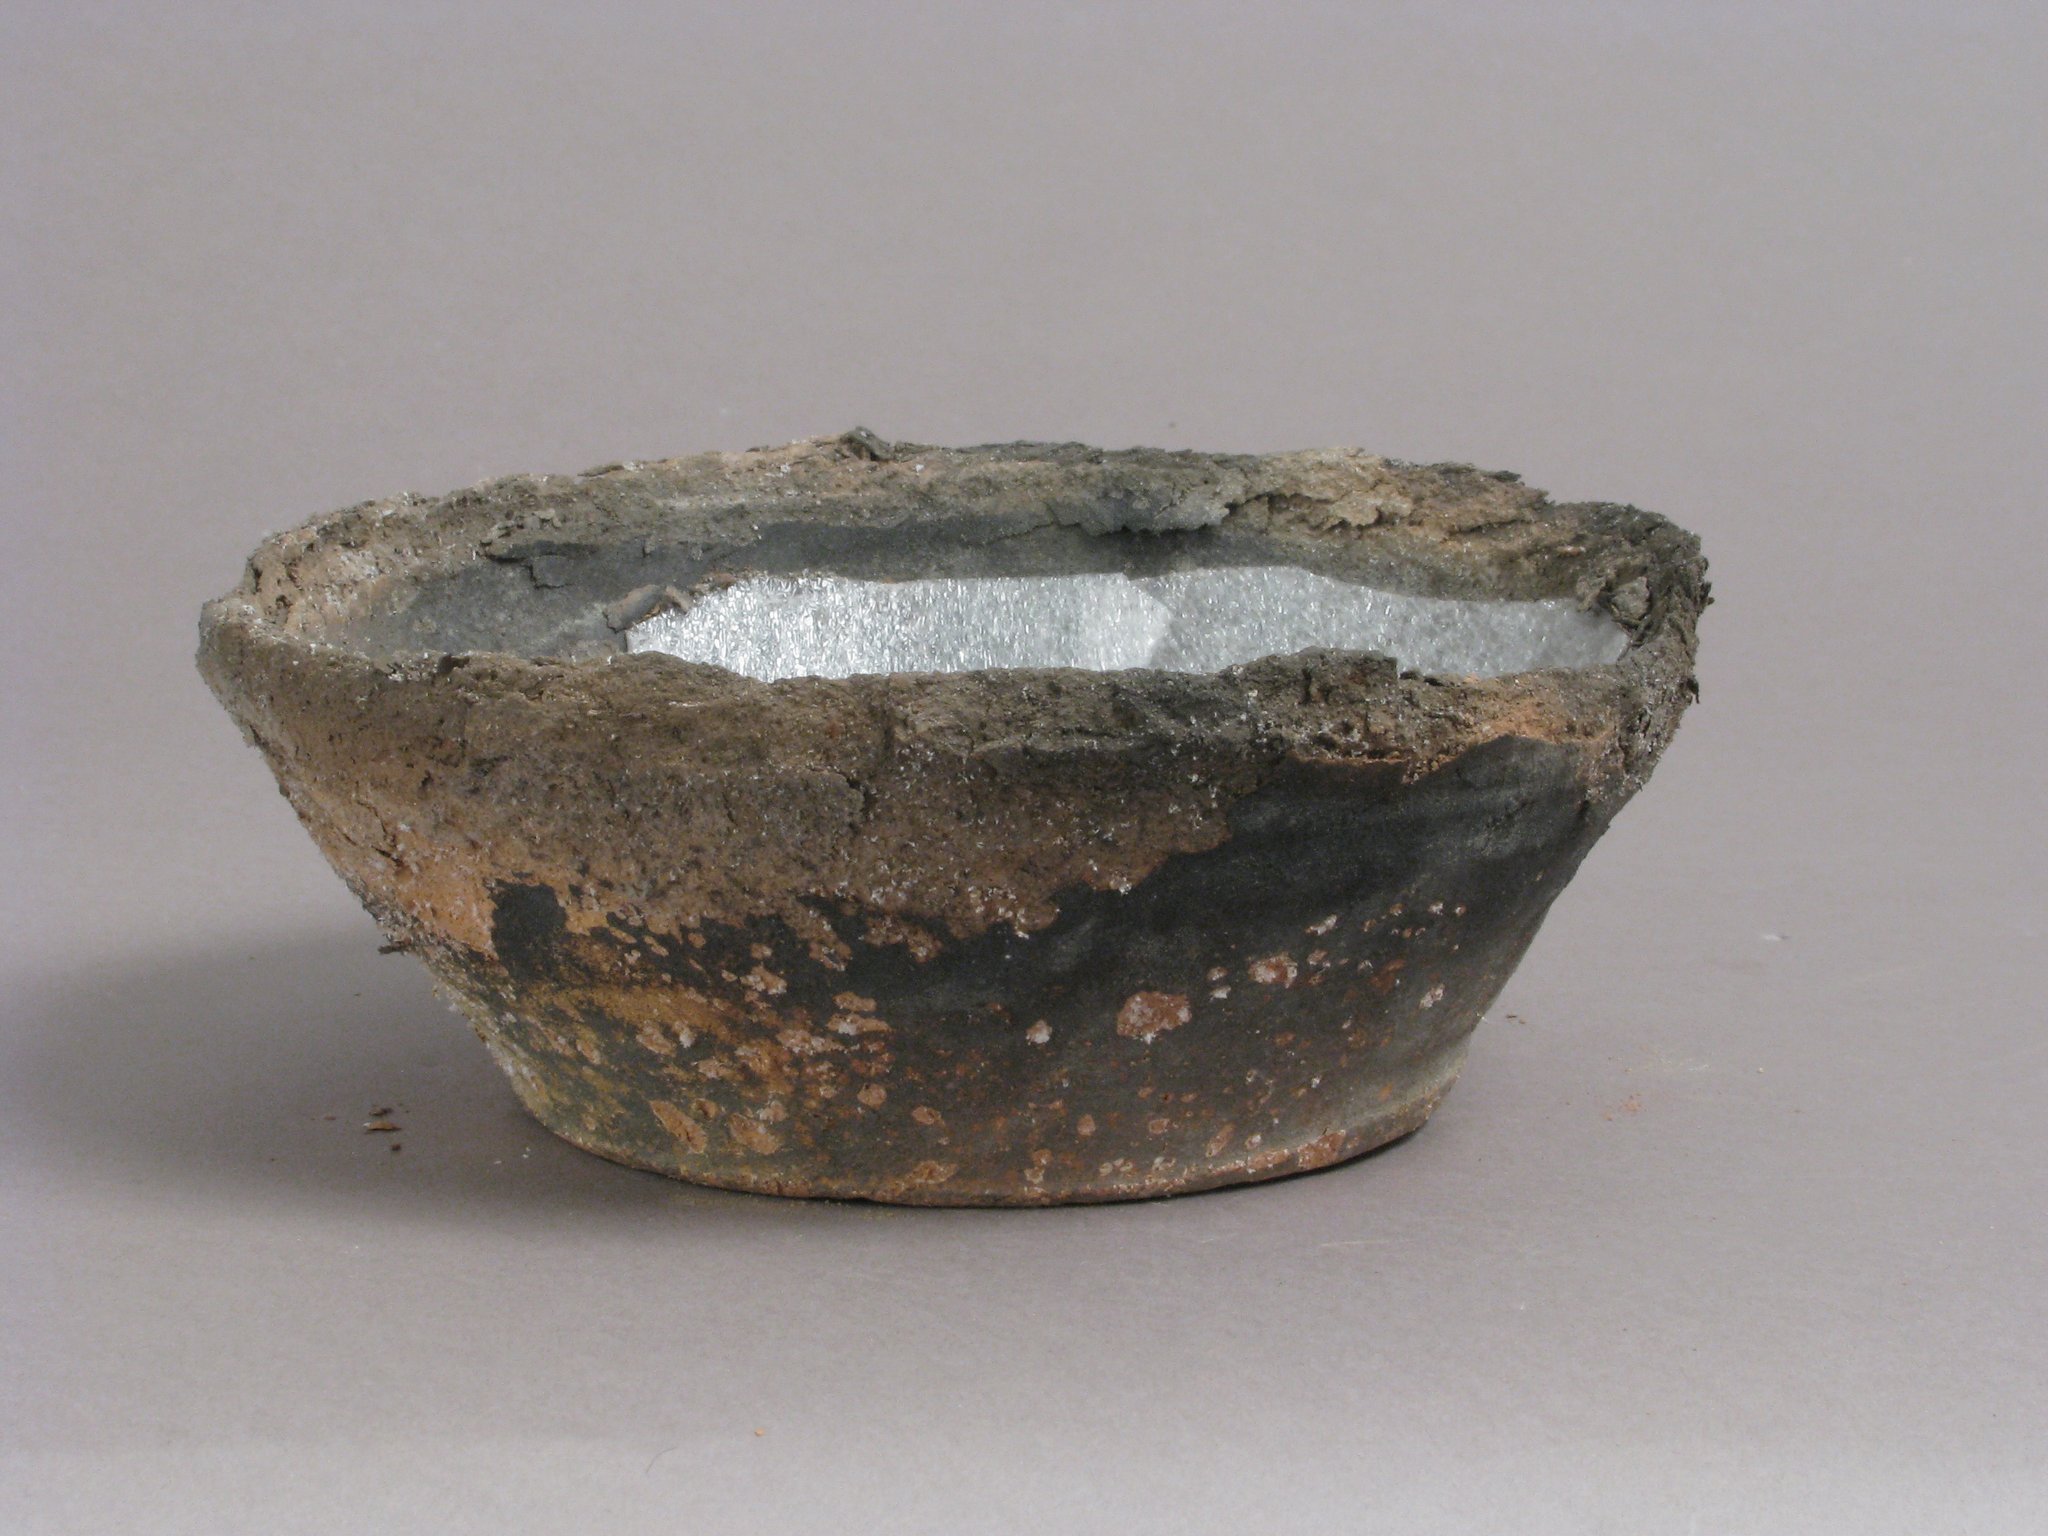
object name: bowl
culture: coptic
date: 301-700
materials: earthenware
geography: egypt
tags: bowls